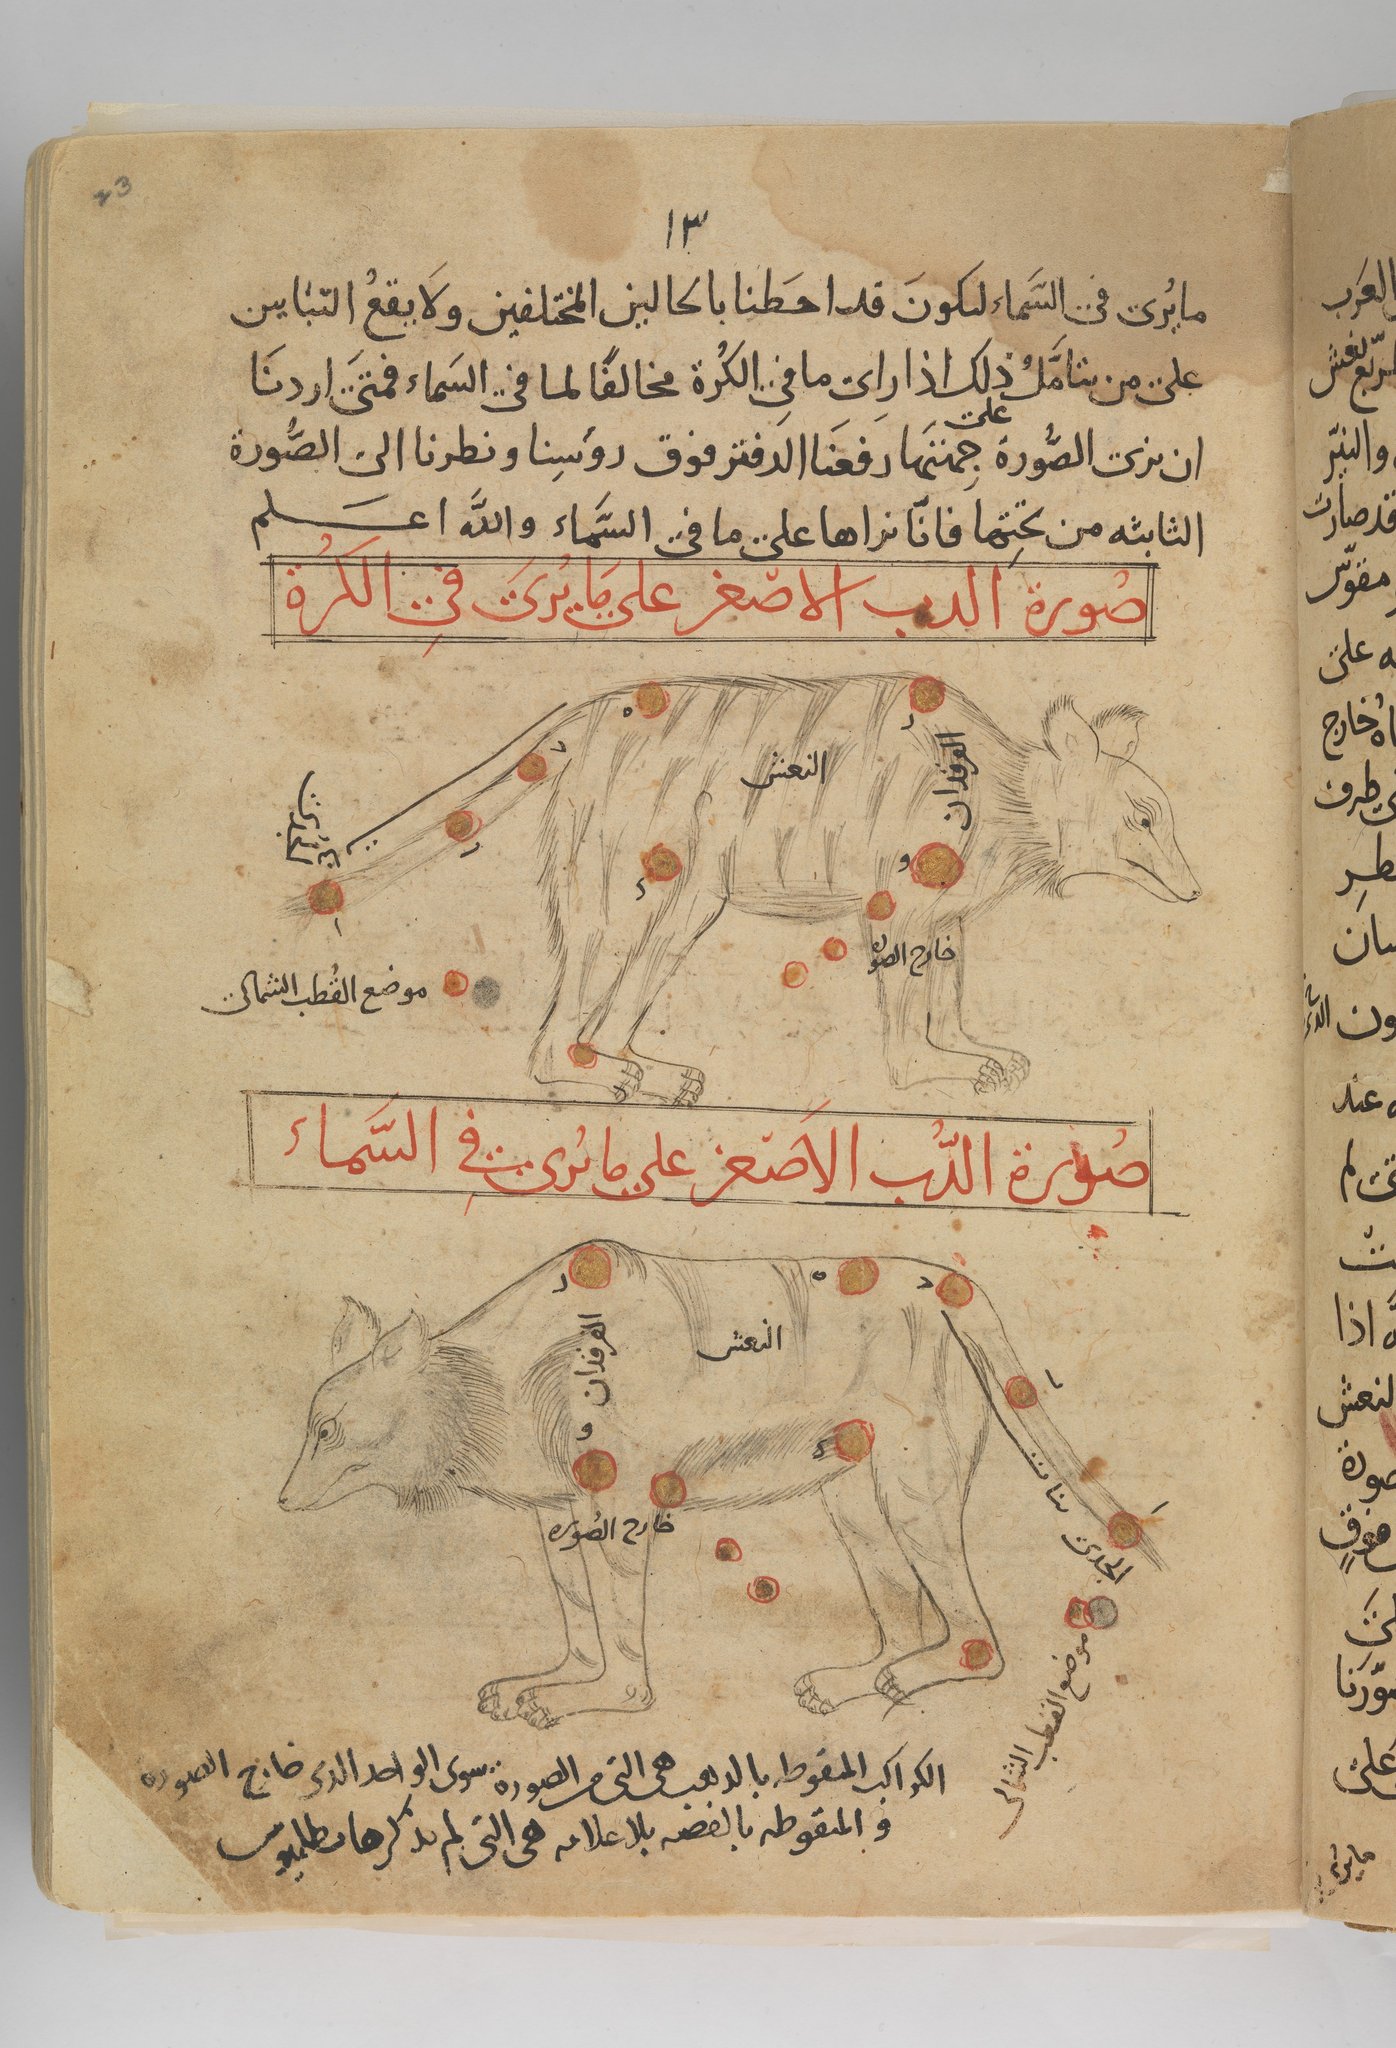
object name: illustrated manuscript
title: Kitab suwar al-kawakib al-thabita (Book of the Images of the Fixed Stars) of al-Sufi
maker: `abd al-rahman al-sufi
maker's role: author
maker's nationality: iranian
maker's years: 903-986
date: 1467-1500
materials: gold, ink, leather, paper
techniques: bookbinding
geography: iran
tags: astronomy